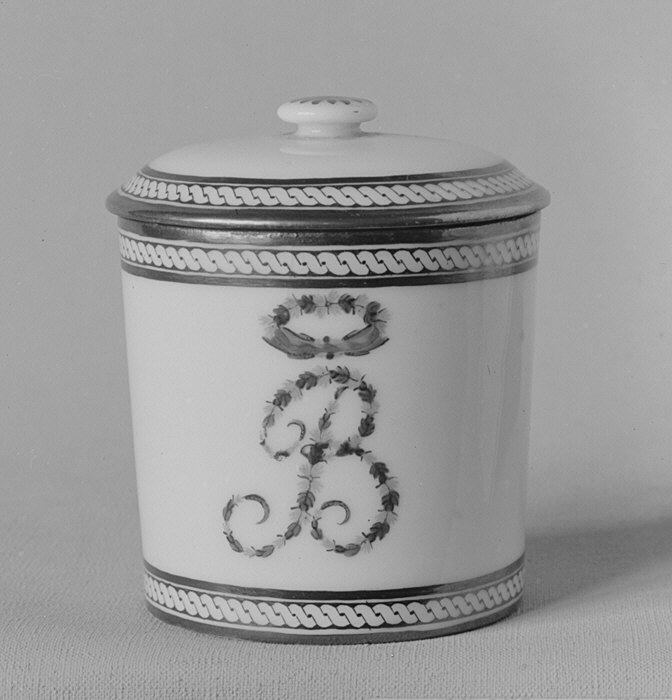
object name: jar with cover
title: Jar with cover (part of a traveling tea service)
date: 1788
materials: hard paste porcelain